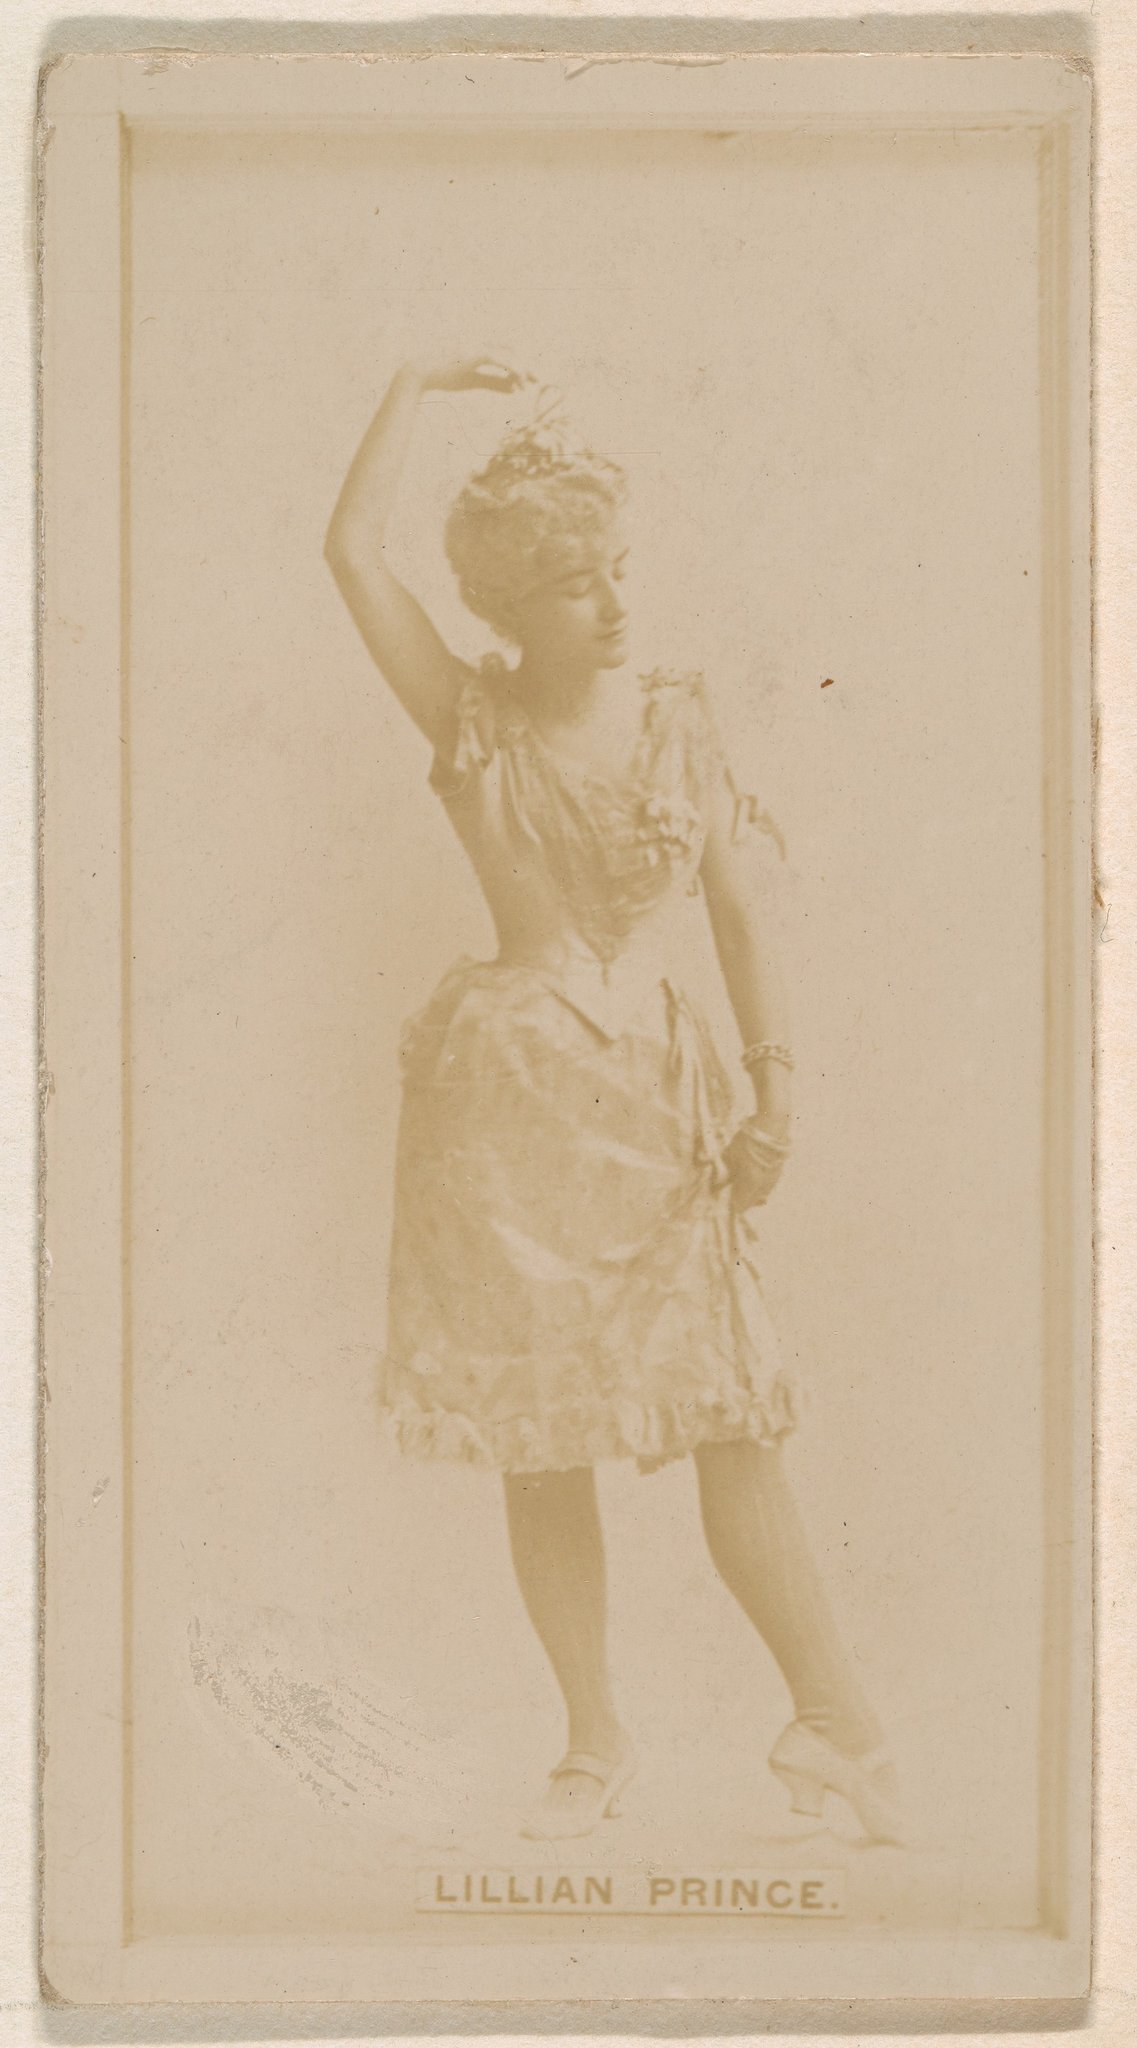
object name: photograph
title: Lillian Prince, from the Actresses series (N245) issued by Kinney Brothers to promote Sweet Caporal Cigarettes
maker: kinney brothers tobacco company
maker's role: publisher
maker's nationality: american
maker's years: 1869-2011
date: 1890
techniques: albumen silver print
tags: portraits,women,actresses